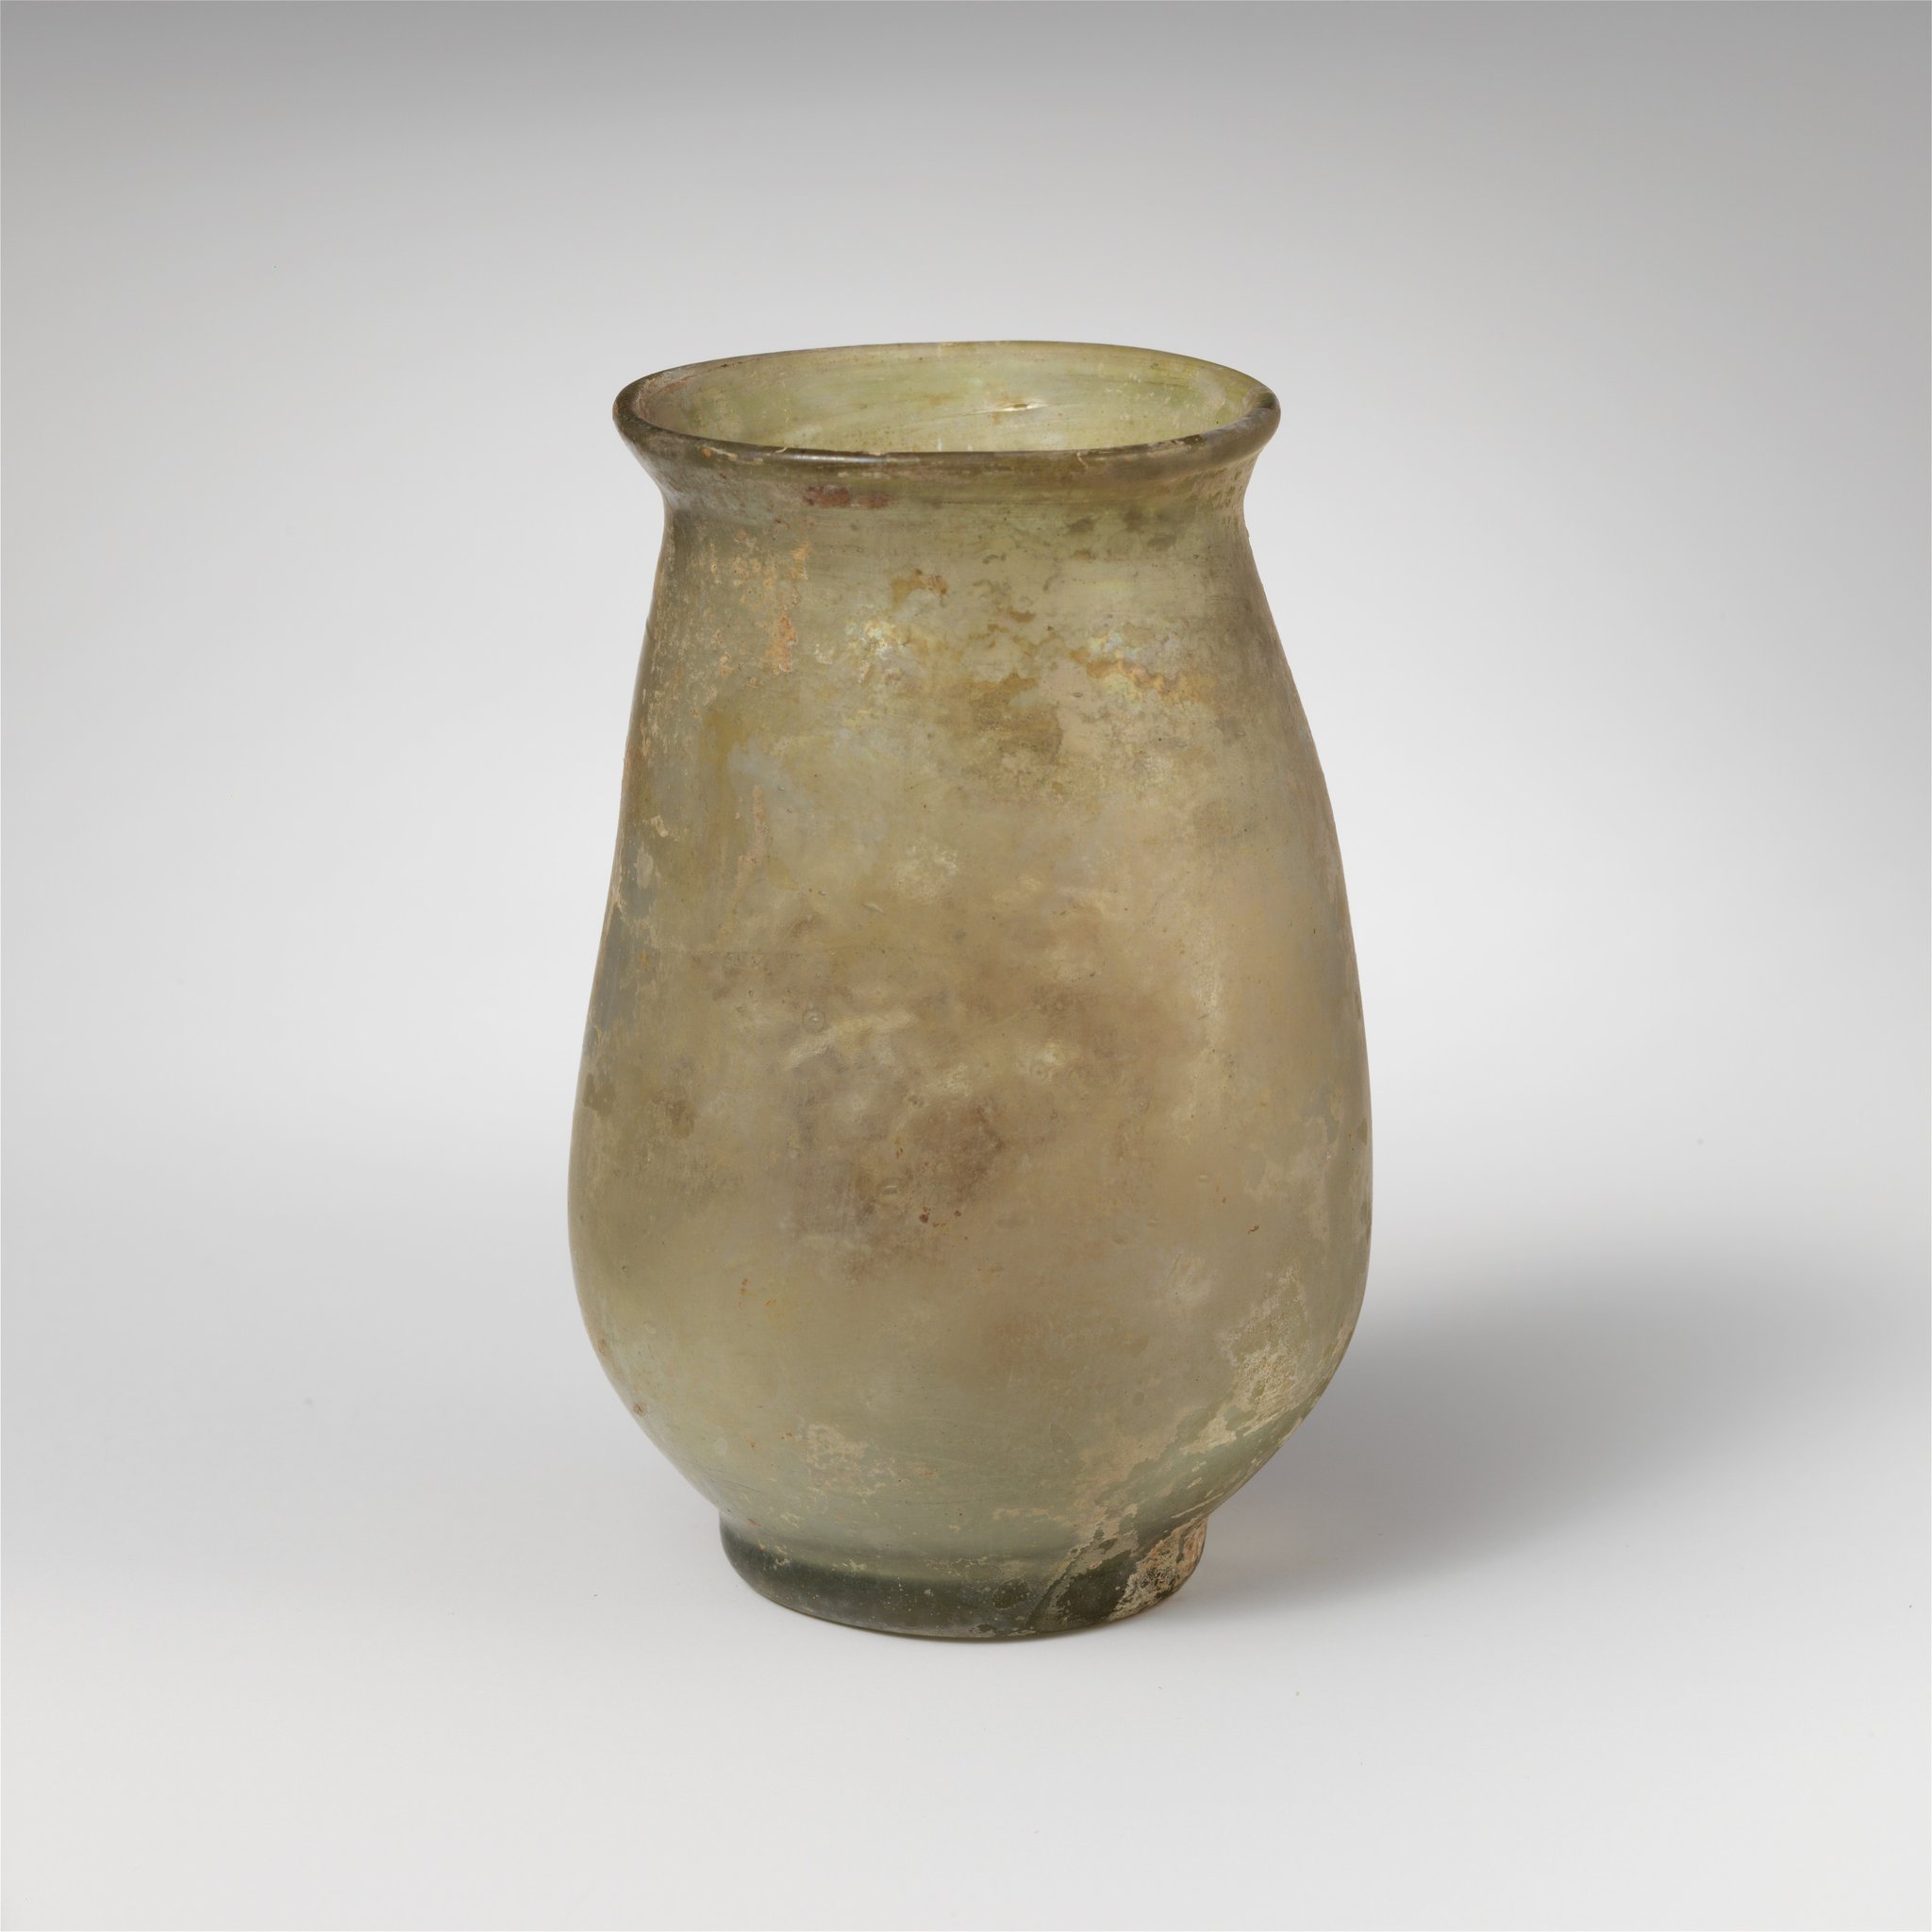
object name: beaker or jar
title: Glass beaker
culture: roman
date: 101-300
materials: glass